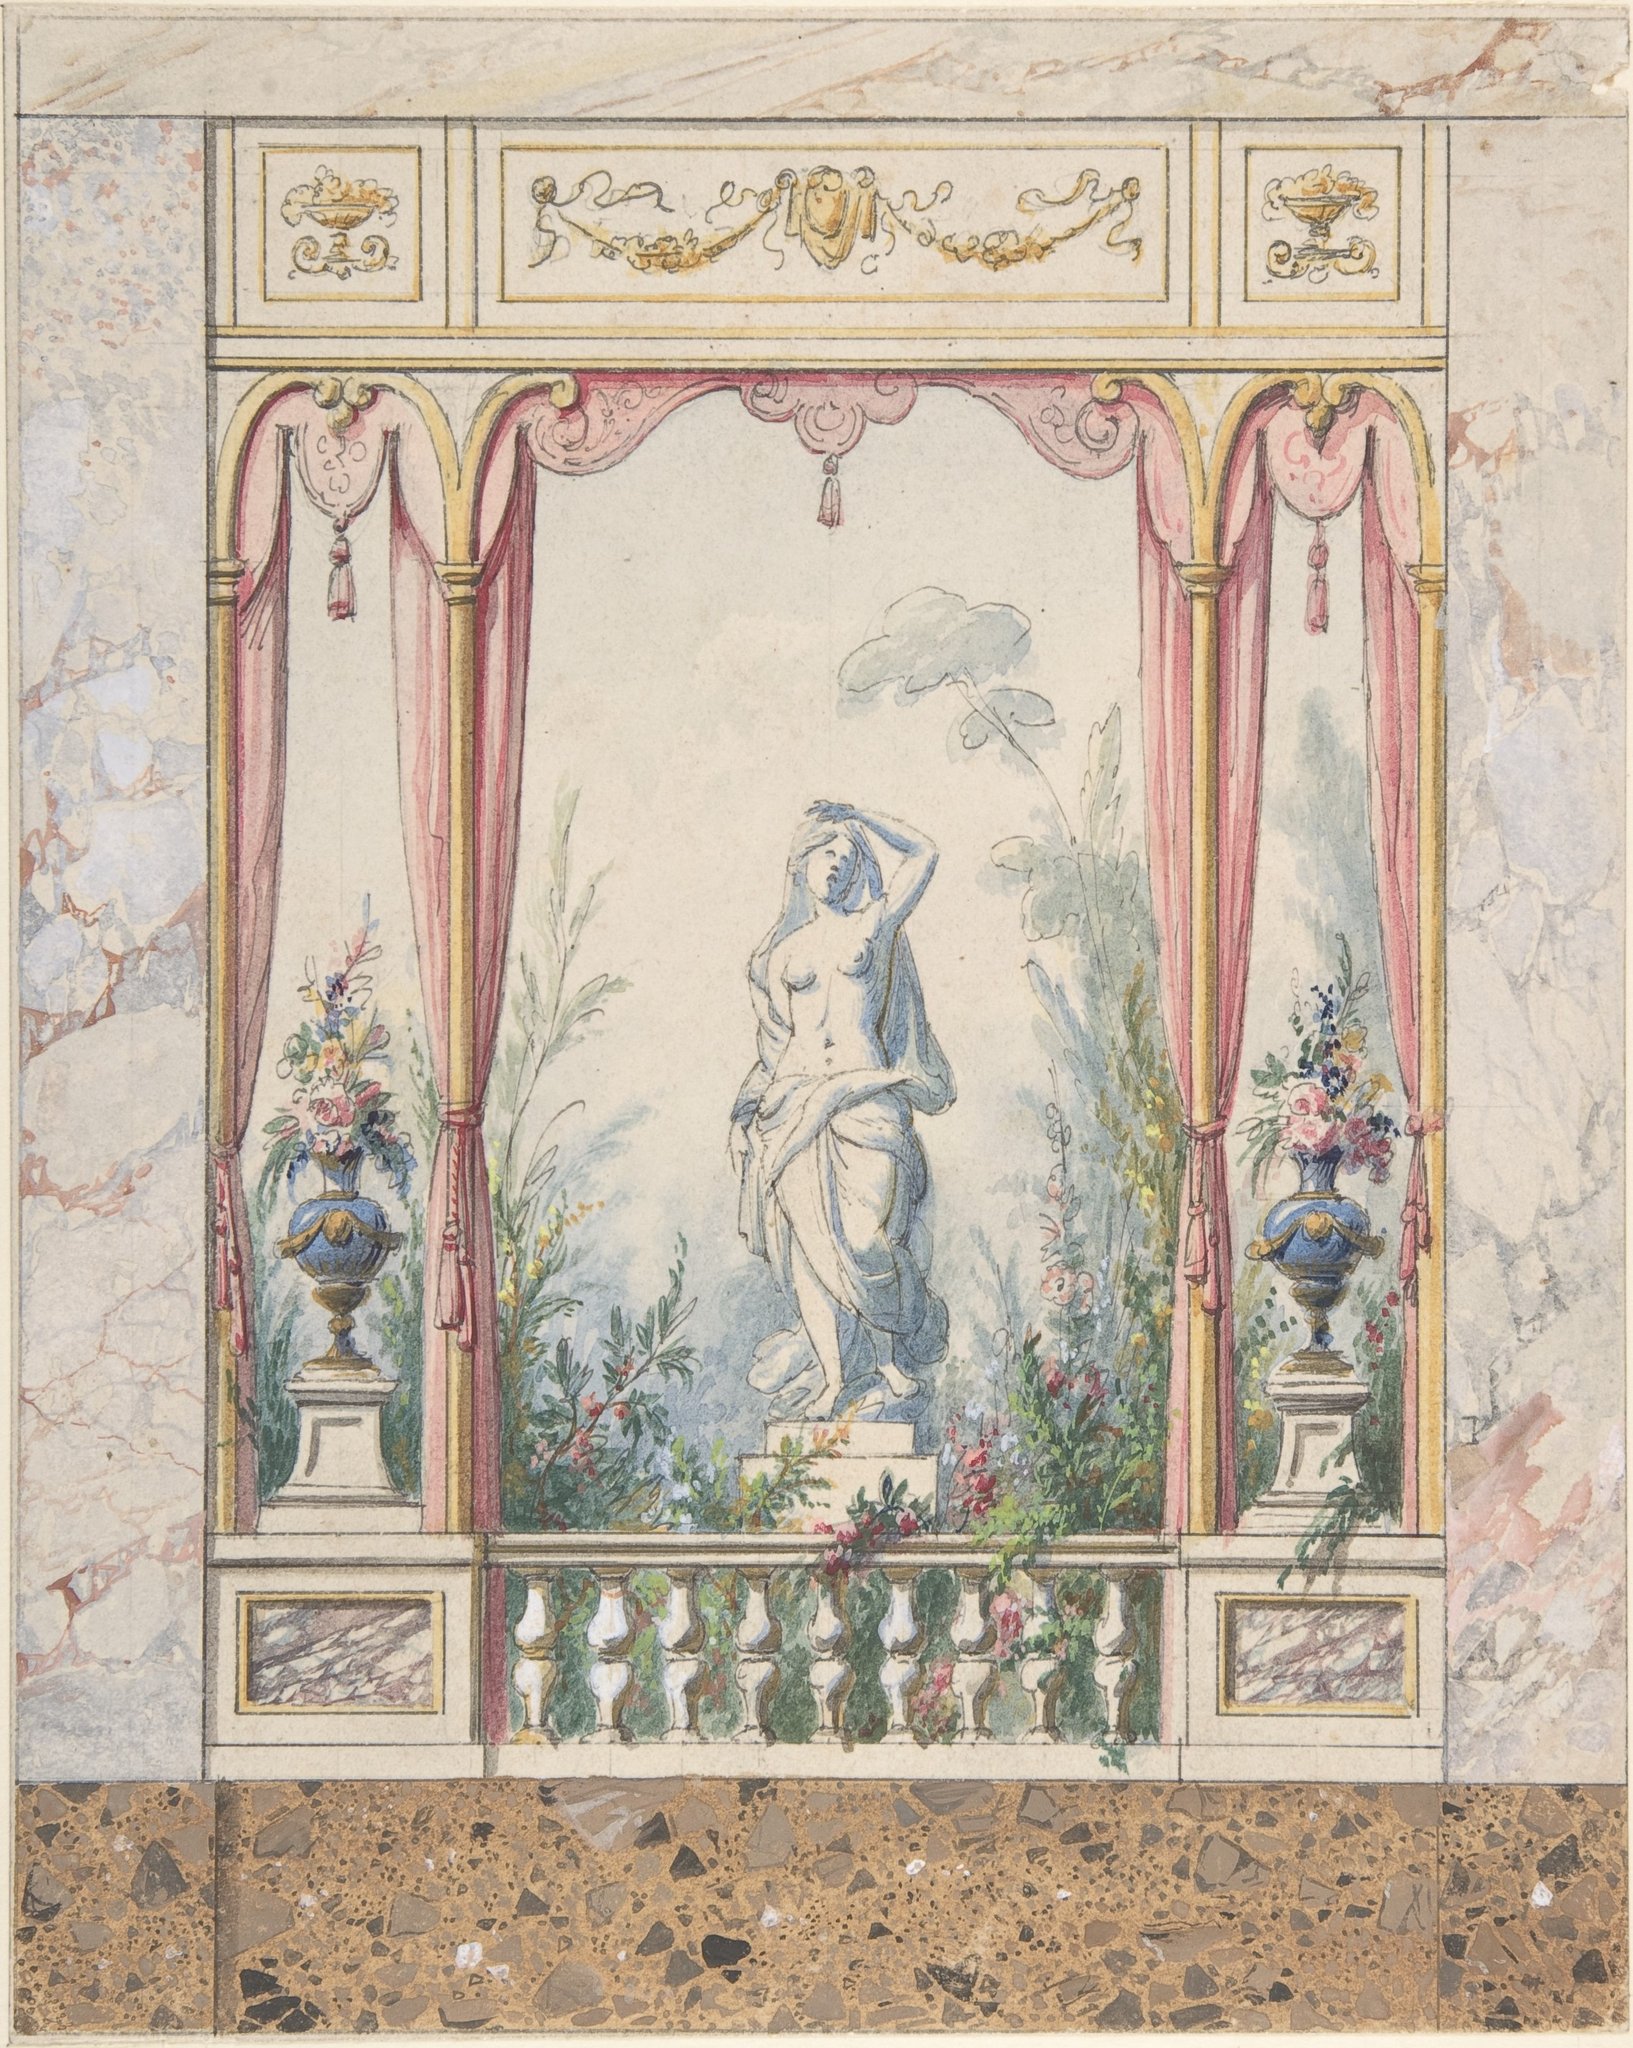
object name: drawing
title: Design for an Interior with a Window into a Garden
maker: anonymous, italian, early 19th century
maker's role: artist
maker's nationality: italian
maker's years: 1800-1825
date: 1800-1850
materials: watercolor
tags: windows,gardens,female nudes